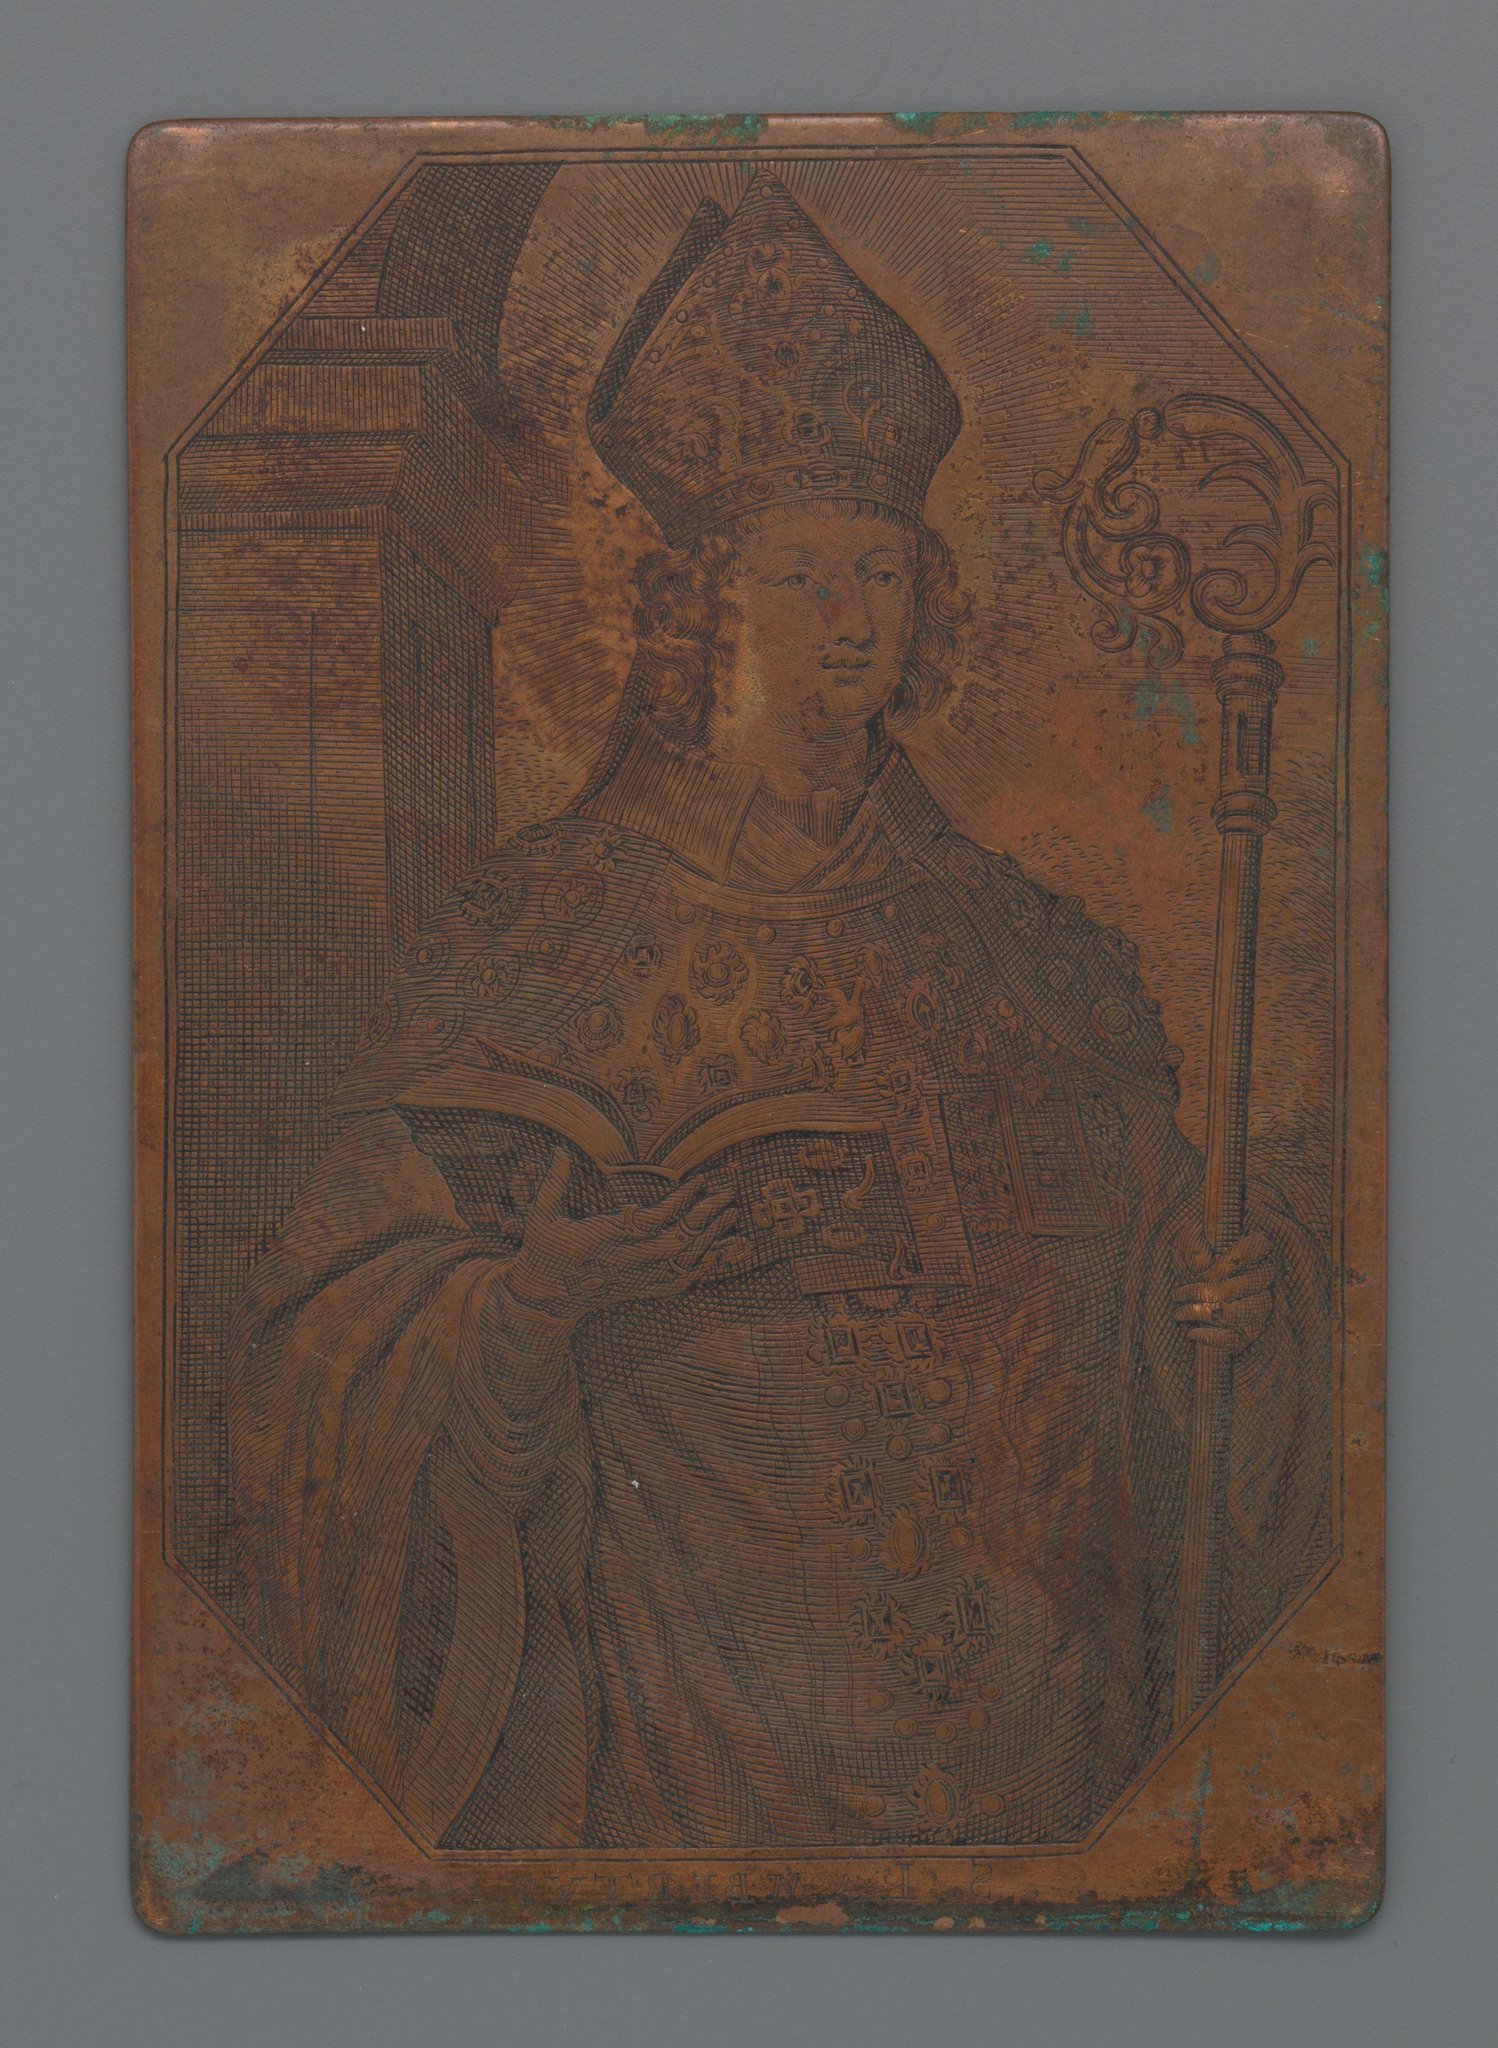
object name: copper plate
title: Koperplaat met de Heilige Lambertus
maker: franz huybrechts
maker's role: print maker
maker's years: 1630-1687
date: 1640-1687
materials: copper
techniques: engraving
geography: antwerp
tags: saints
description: De platen (RP-D-2014-9-1 t/m 35) zijn vrijwel allemaal vervaardigd door anonieme graveurs werkend voor de Antwerpse uitgevers Cornelis Galle, Frans Huberti (Huybrechts), Theodor van Merlen II en Michel Bunel. Vermoedelijk zijn ze uiteindelijk beland in één fonds, wellicht dat van Michel Bunel (1670-1739) en warden sindsdien bij elkaar bewaard. Afwijkend is de grote prent van Henry Verbruggen met een weergave van de Preekstoel uit de St. Gudule-kerk te Brussel. Twee prenten zijn verpakt in een oude afdruk van de prent, zoals te doen gebruikelijk in uitgeverijen (vergl. oude platen in Museum Plantijn Moretus, Antwerpen). Van 8 platen heeft de vorige eigenaar afdrukken laten maken op modern papier.